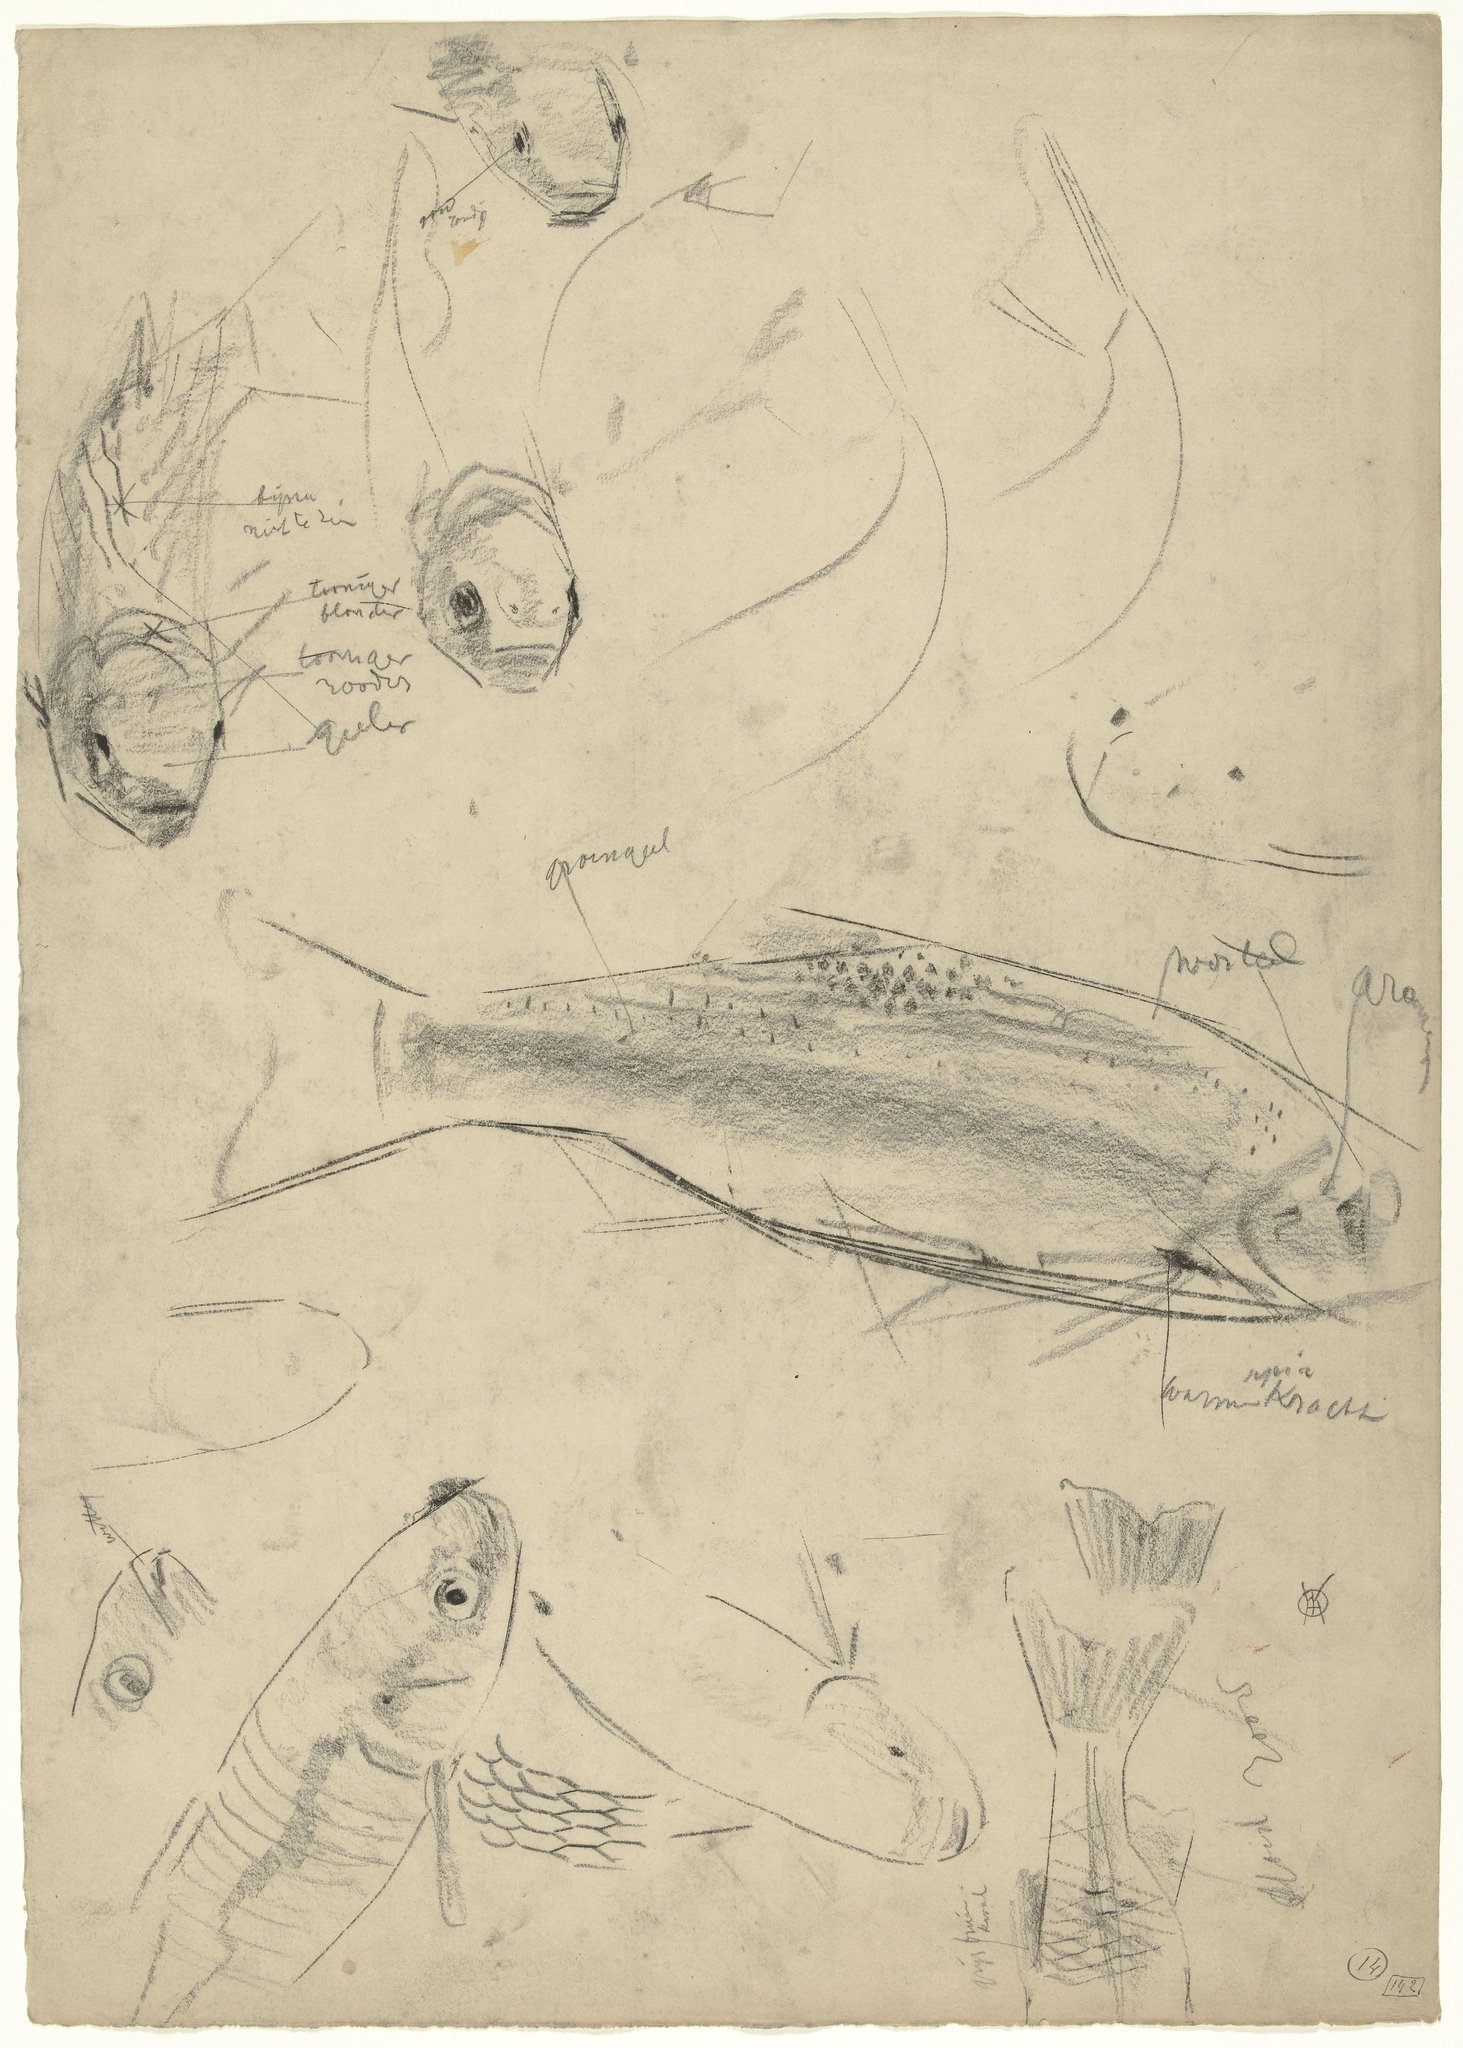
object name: drawing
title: Studies van voorns, met kleurnotities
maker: gerrit willem dijsselhof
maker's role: designer, draughtsman, print maker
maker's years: 1866-1924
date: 1876-1924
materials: chalk, paper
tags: bony fishes: rock bass